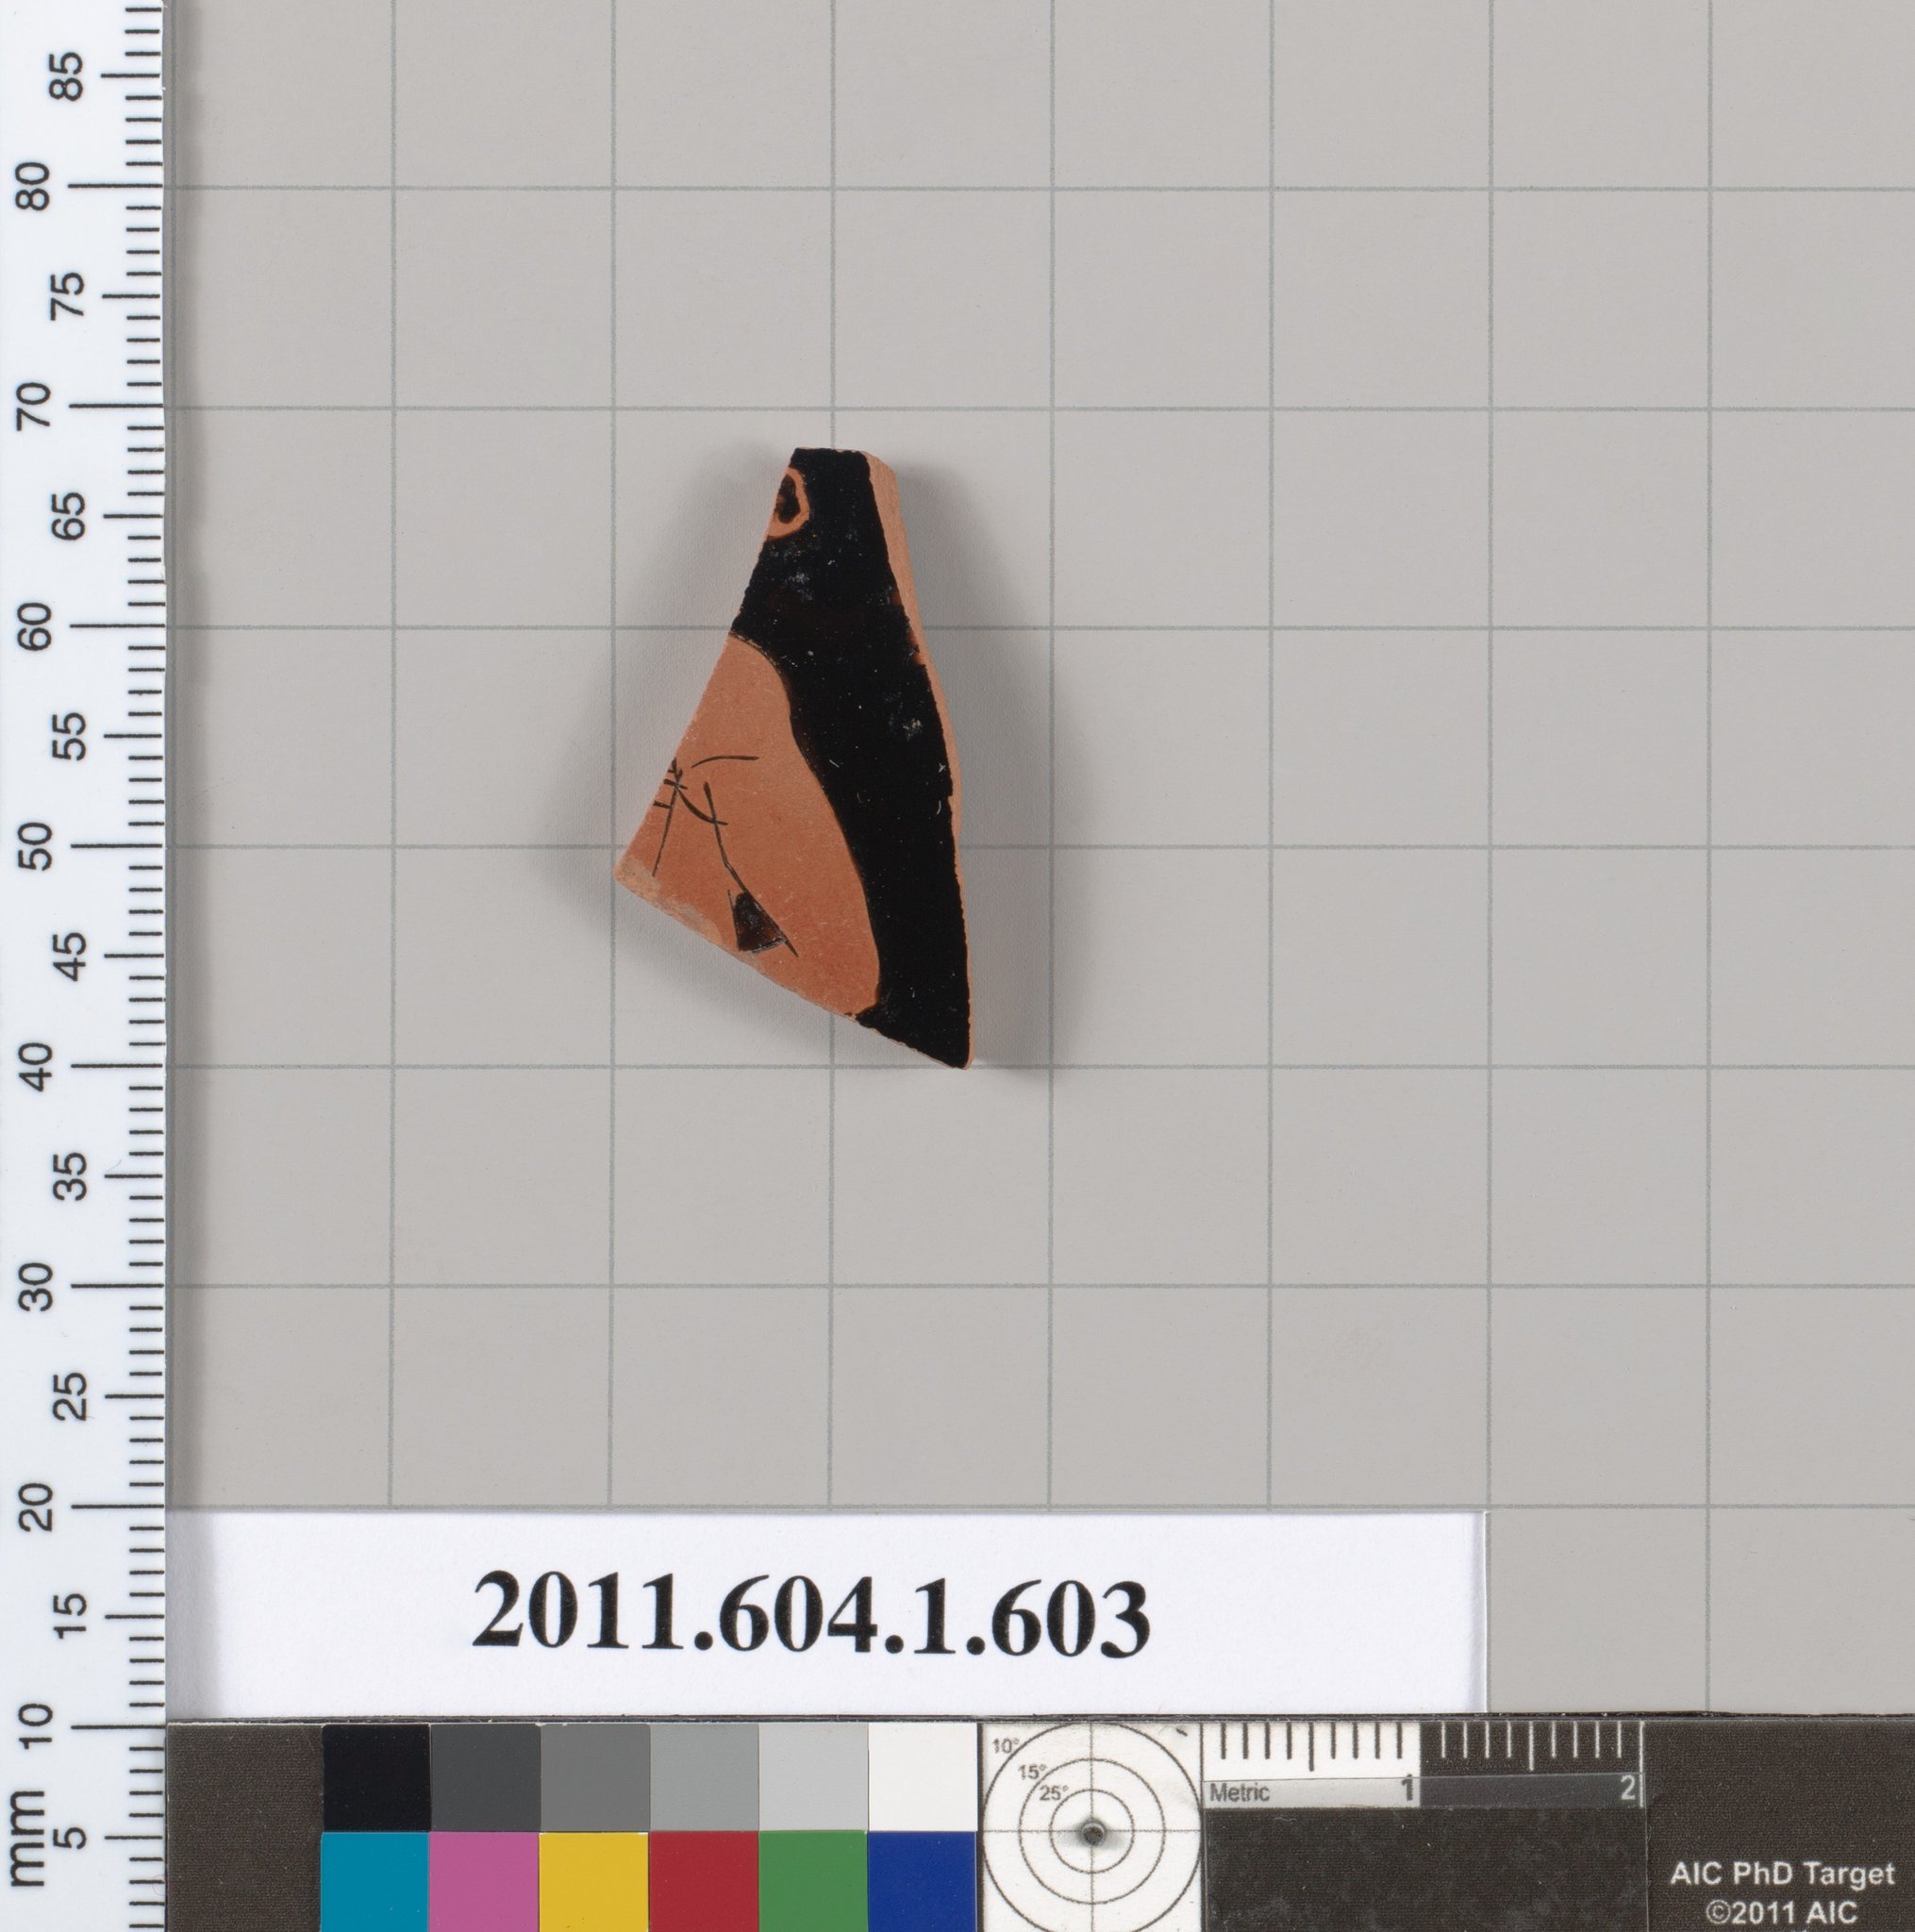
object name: kylix fragment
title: Terracotta fragment of a kylix (drinking cup)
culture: greek, attic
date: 475-451 BCE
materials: terracotta